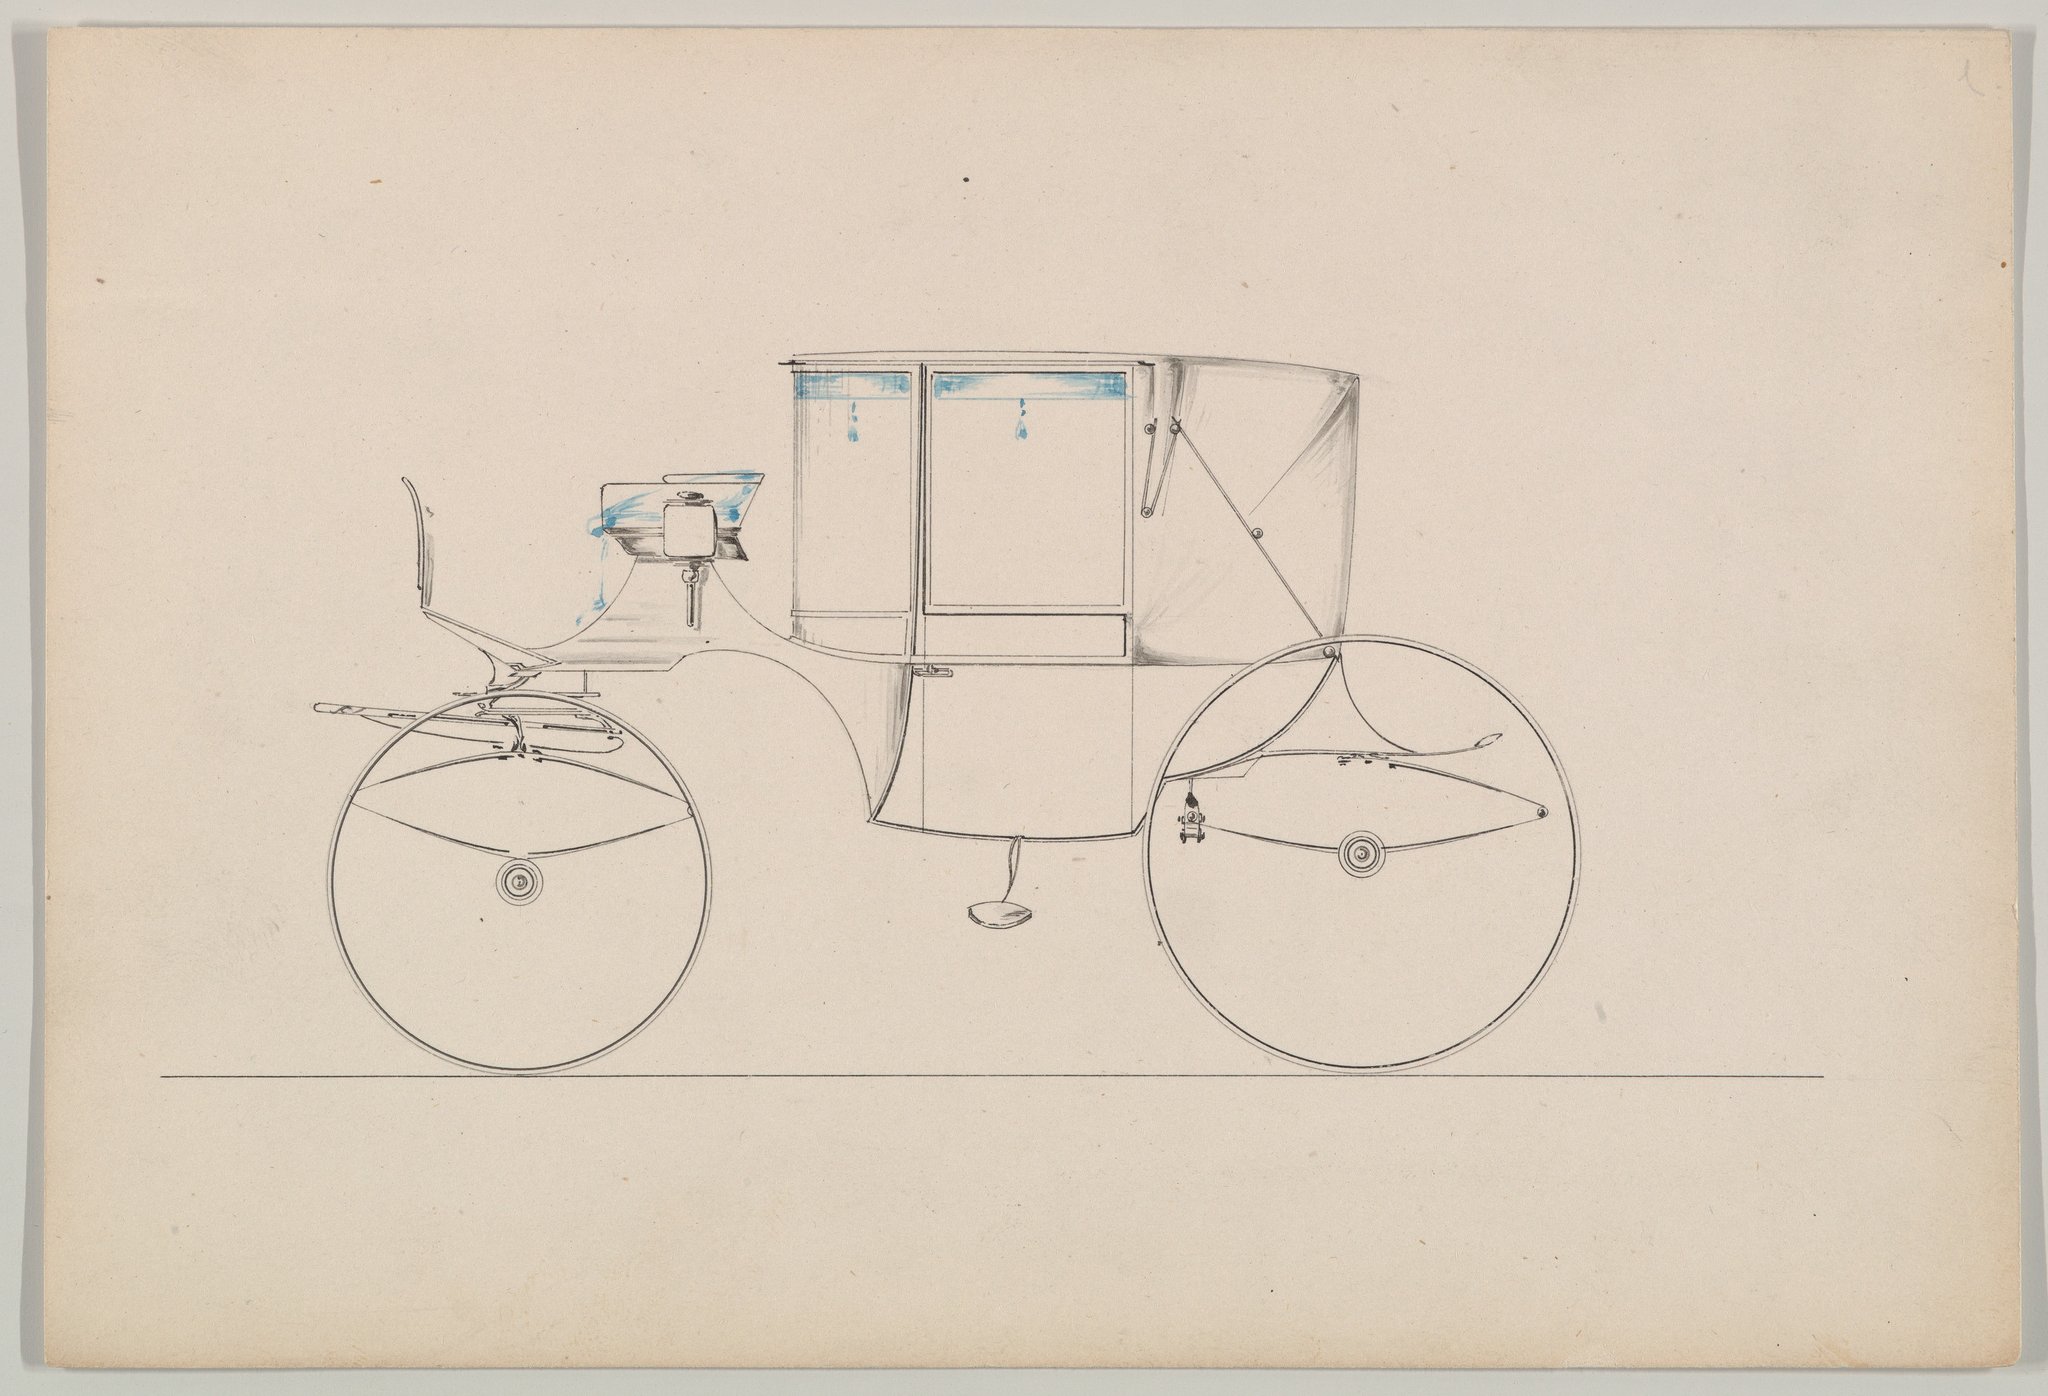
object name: drawing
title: Extended Front Landaulet (unnumbered)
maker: brewster & co.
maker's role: manufacturer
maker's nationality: american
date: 1850-1870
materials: gouache, ink, watercolor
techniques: pen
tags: carriages